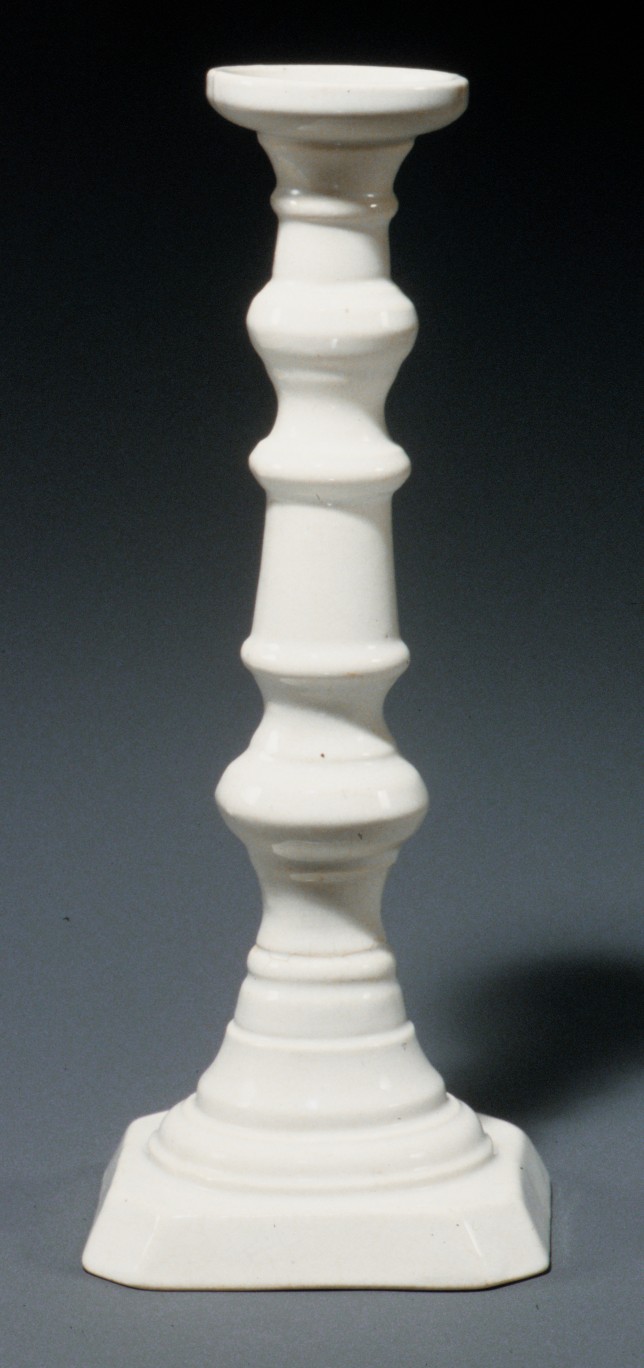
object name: candlestick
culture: american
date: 1845-1860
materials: porcelain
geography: united states